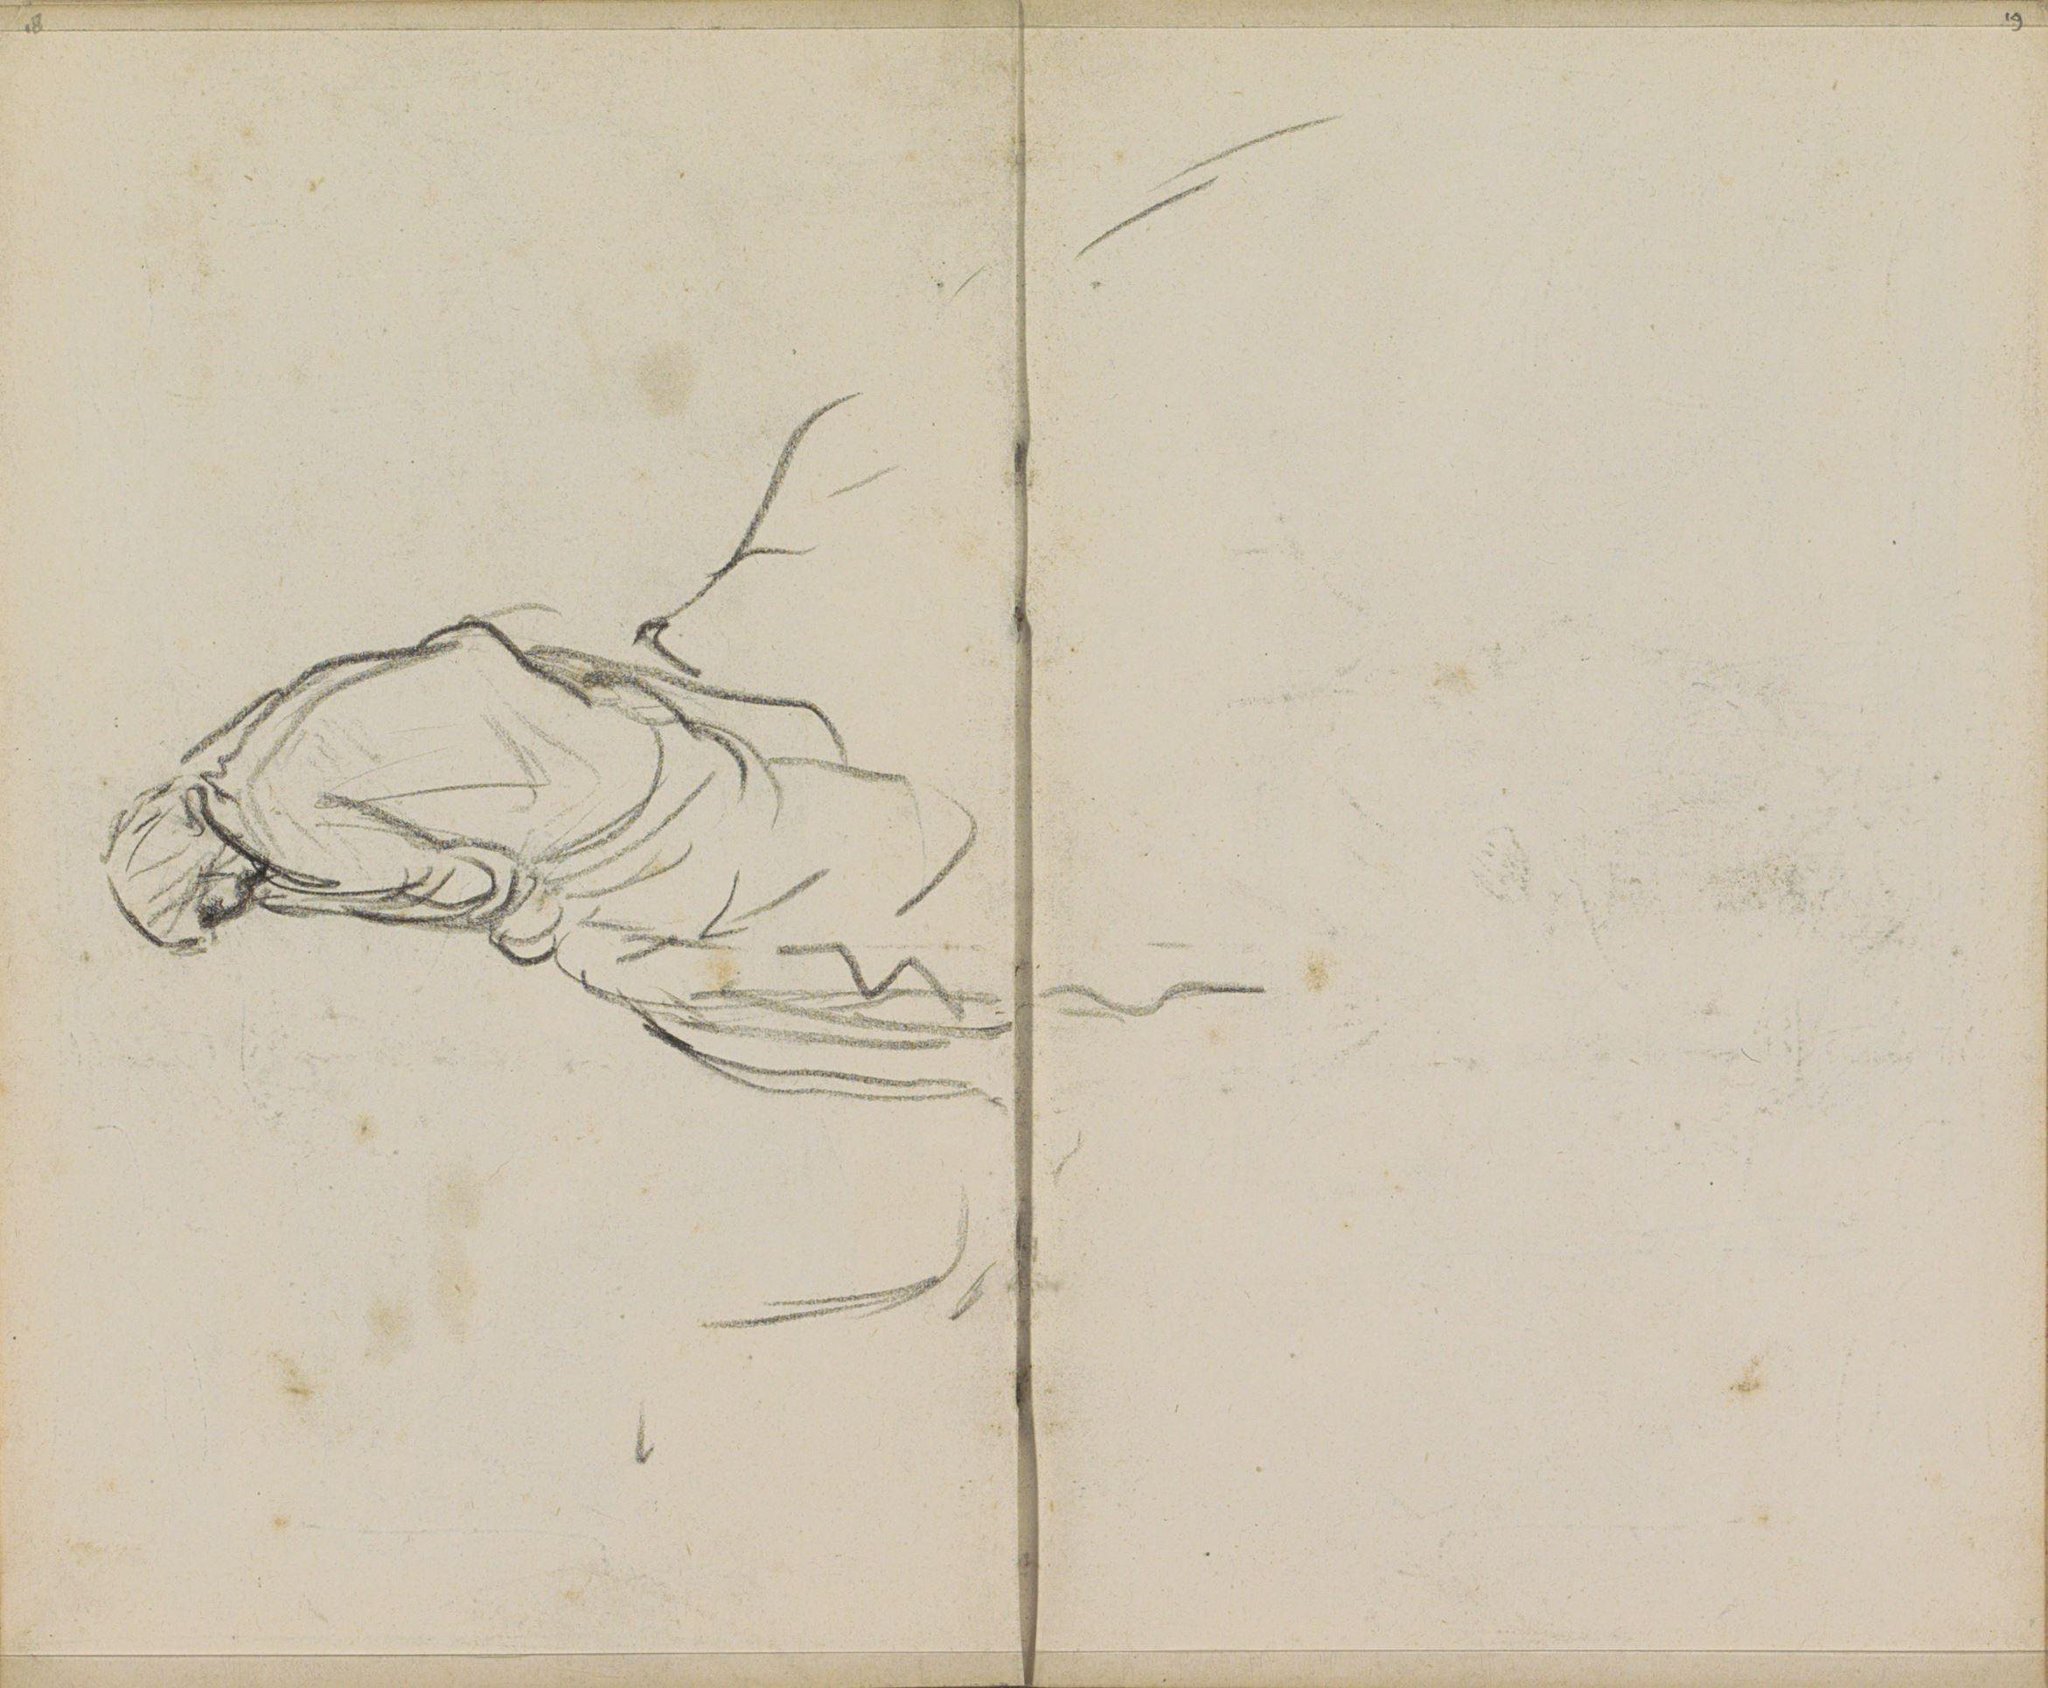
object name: sketchbook leaf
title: Zittende figuur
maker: marius bauer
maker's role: draughtsman, print maker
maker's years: 1867-1932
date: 1904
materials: chalk, paper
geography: egypt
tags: sitting figure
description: De figuur draagt een lang gewaad. Pagina 18 uit een schetsboek met 56 bladen.